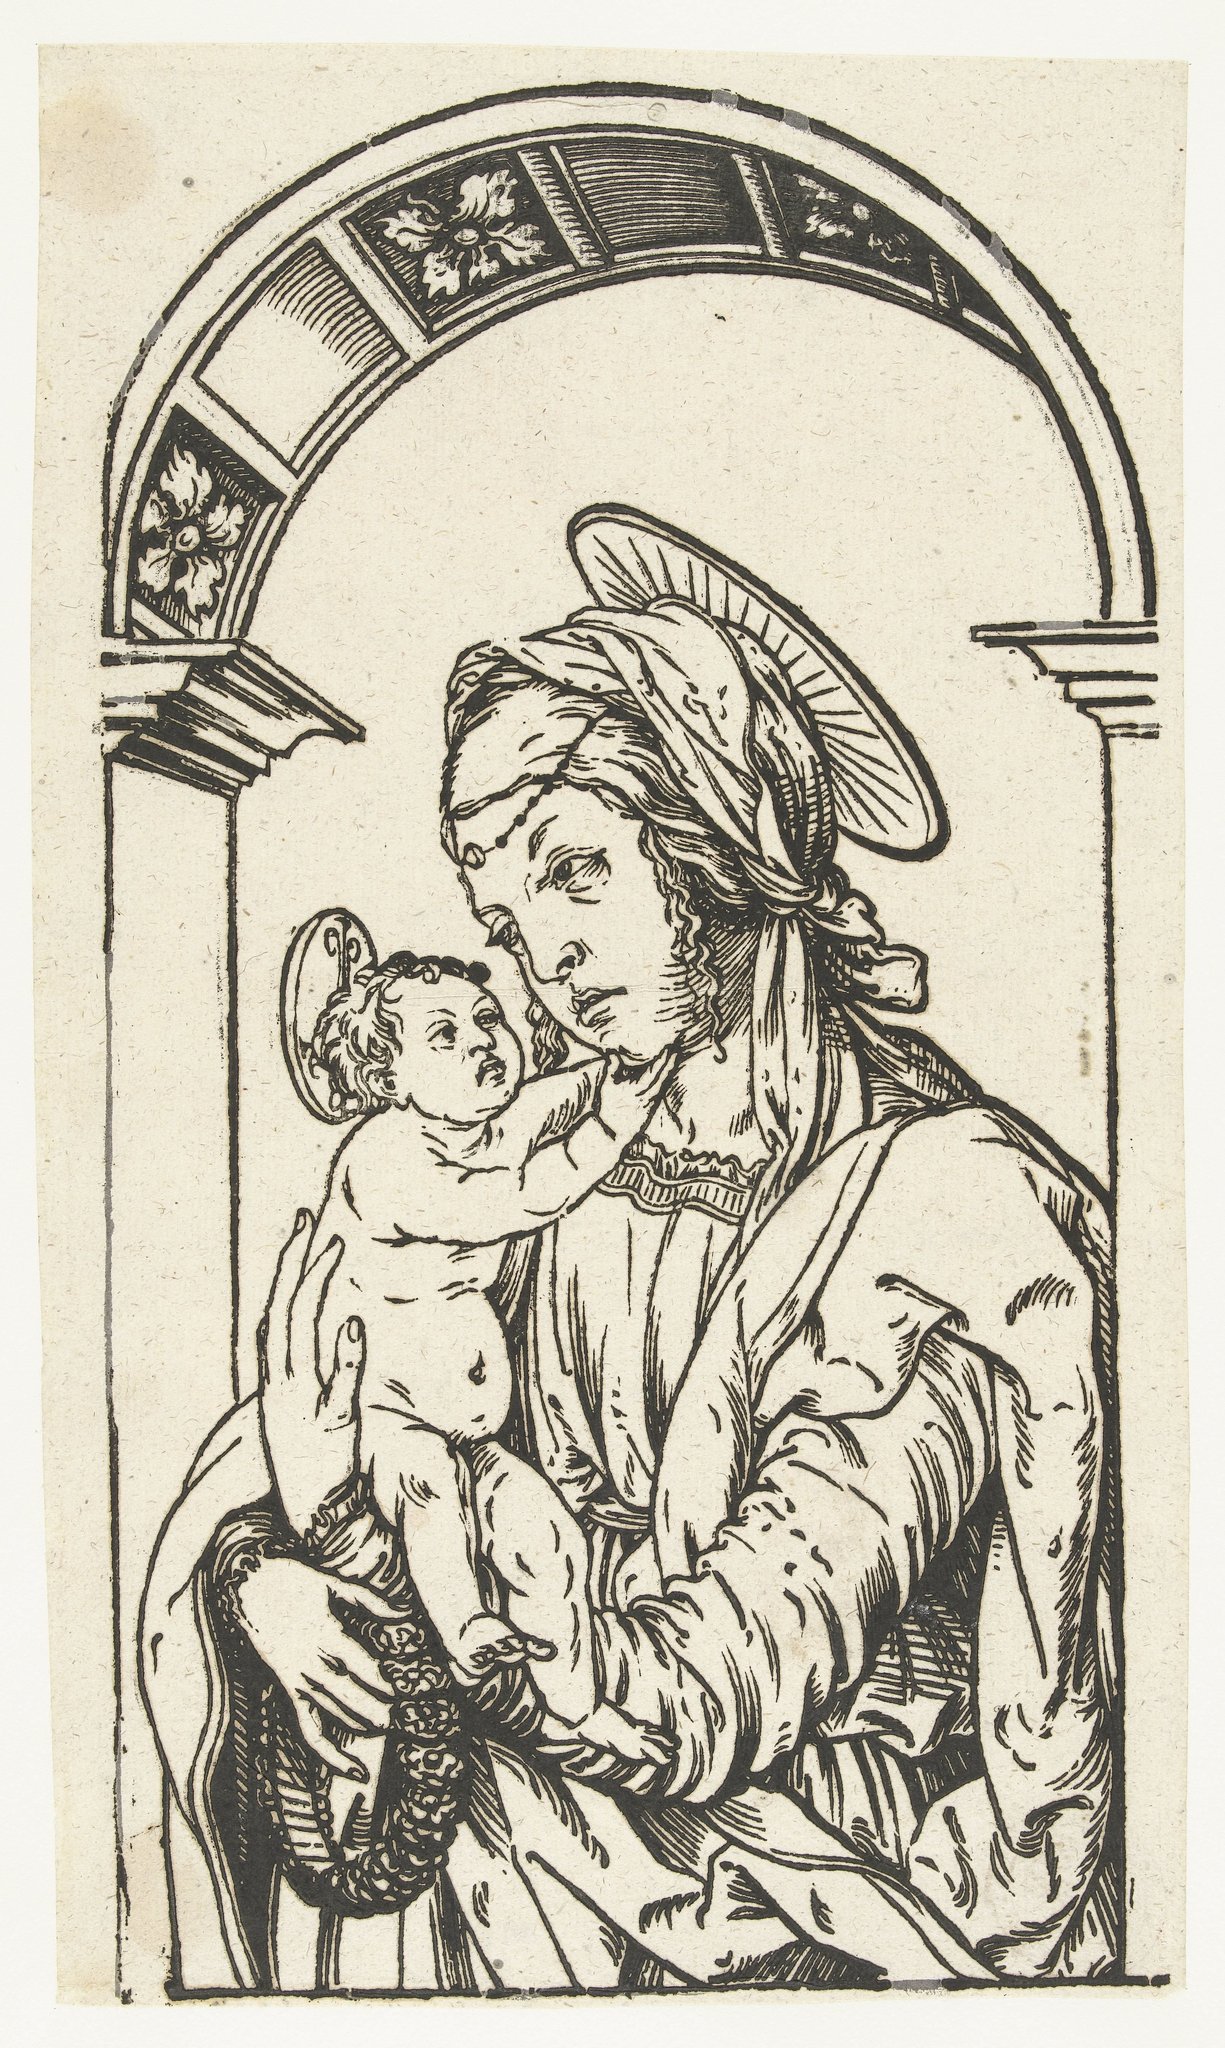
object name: print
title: Maria met kind onder een boog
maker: hans burgkmair (i)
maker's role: draughtsman, print maker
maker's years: 1473-1531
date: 1508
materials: paper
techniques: woodcut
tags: madonna: mary standing (or half-length), christ-child close to her bosom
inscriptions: collector's mark: Lugt 240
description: Maria met het Christuskind zittend op haar arm onder een boog met cassetten. Deze prent is gedrukt met meerdere houtblokken.